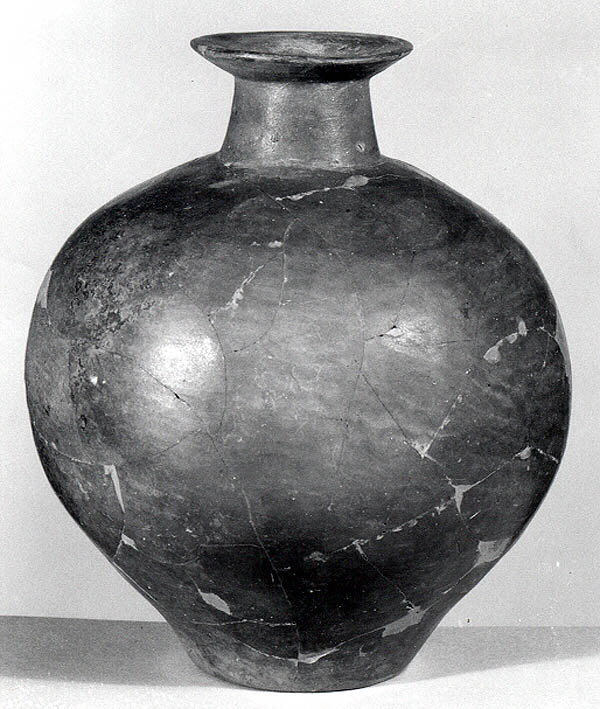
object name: jar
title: Ovoid jar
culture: iranian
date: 3000-2250 BCE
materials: ceramic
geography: iran